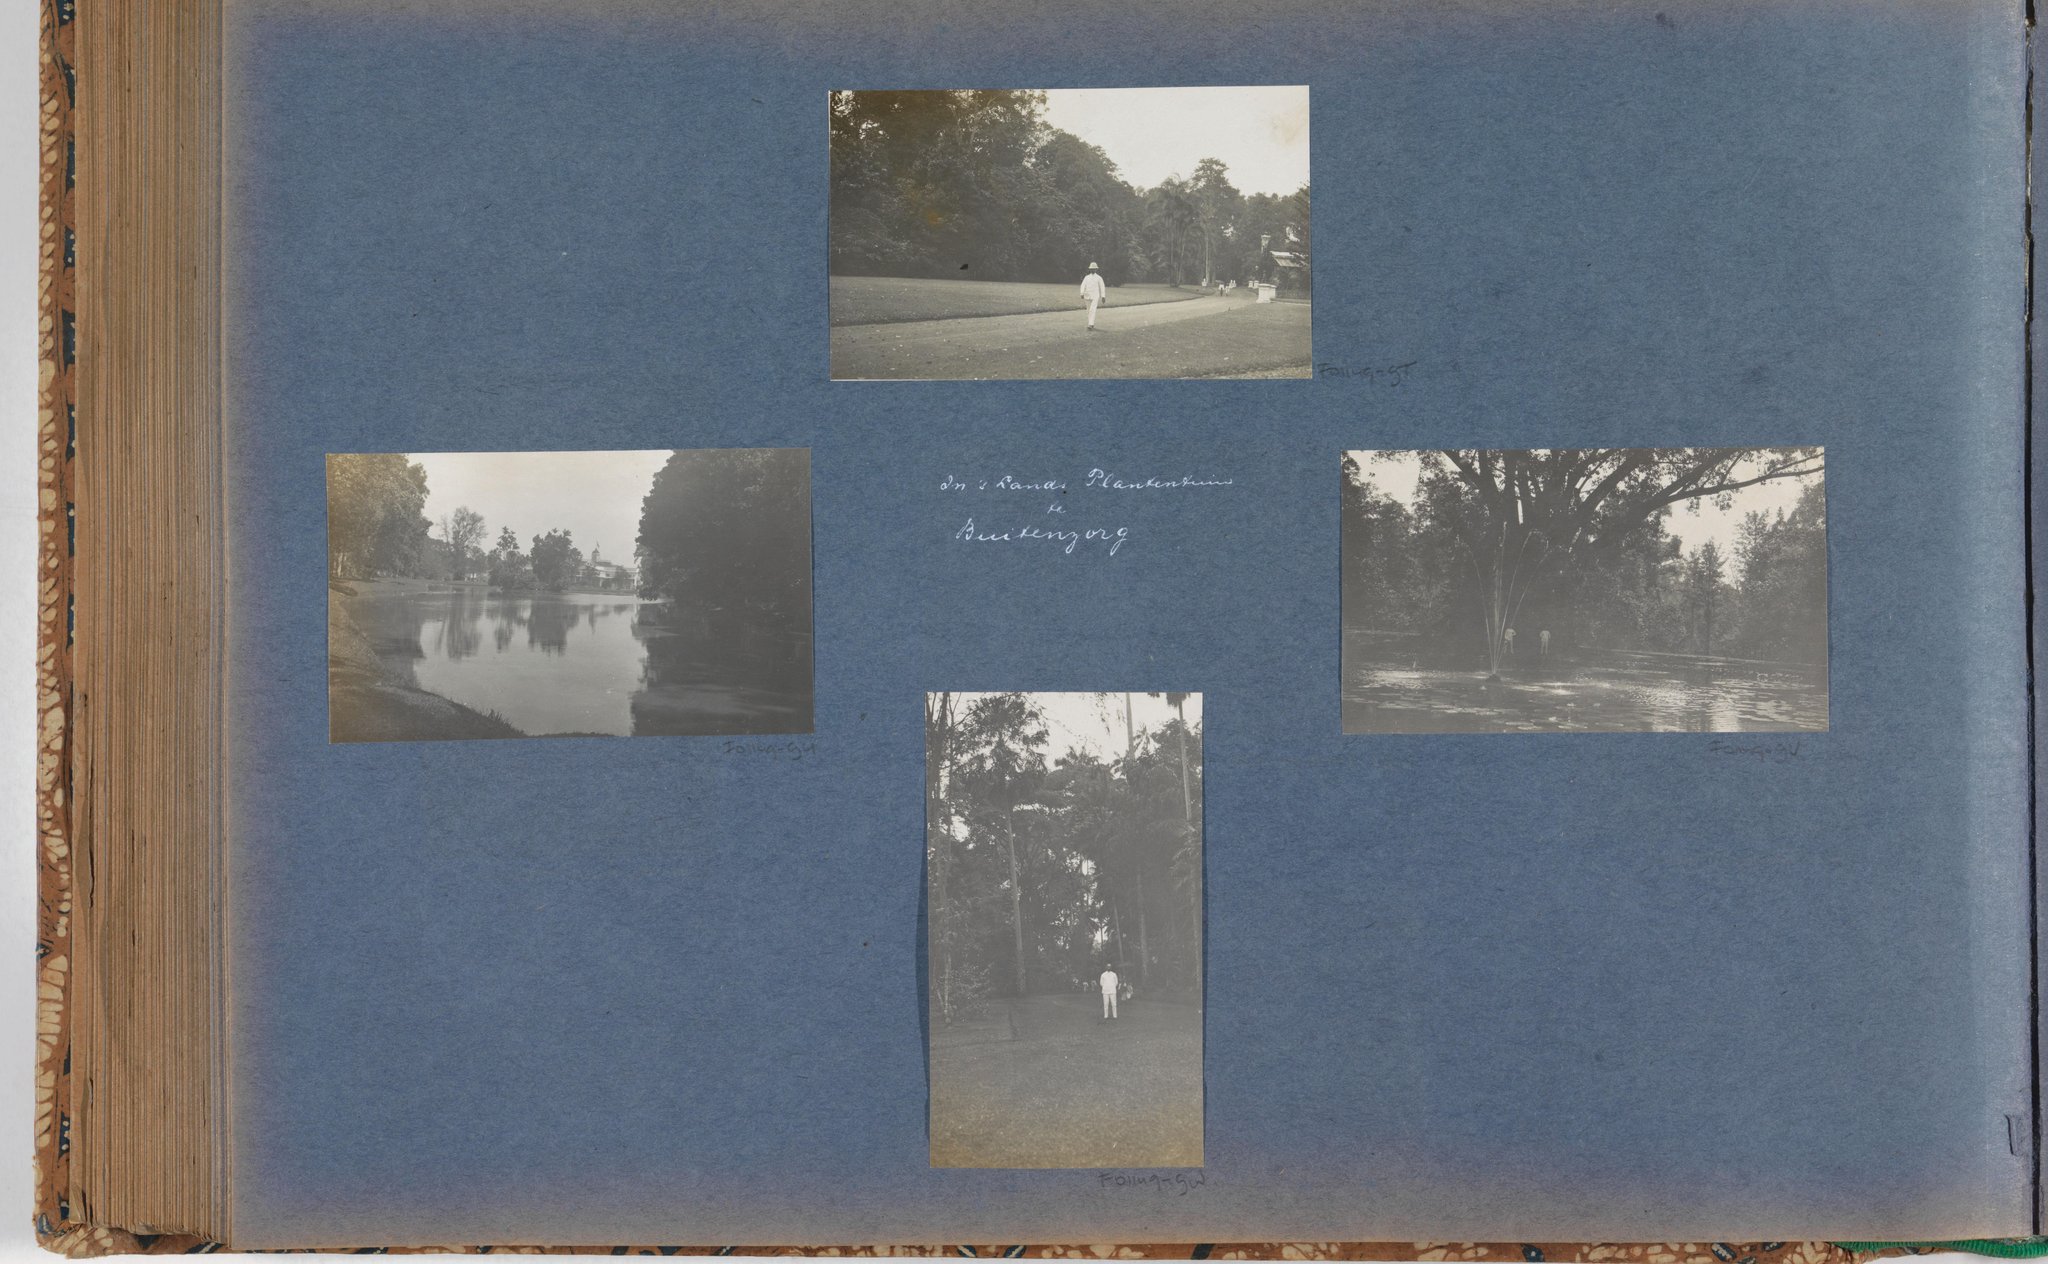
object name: album leaf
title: Europeaan wandelend in 's Lands Plantentuin te Buitenzorg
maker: Anonymous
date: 1900-1920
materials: paper, photographic support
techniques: gelatin silver print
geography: s lands plantentuin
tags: strolling, botanic garden, 'hortus botanicus'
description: Onderdeel van reisalbum met foto's van bedrijvigheid en bezienswaardigheden op Sumatra en Java en van de reis naar en van Nederlands-Indië.